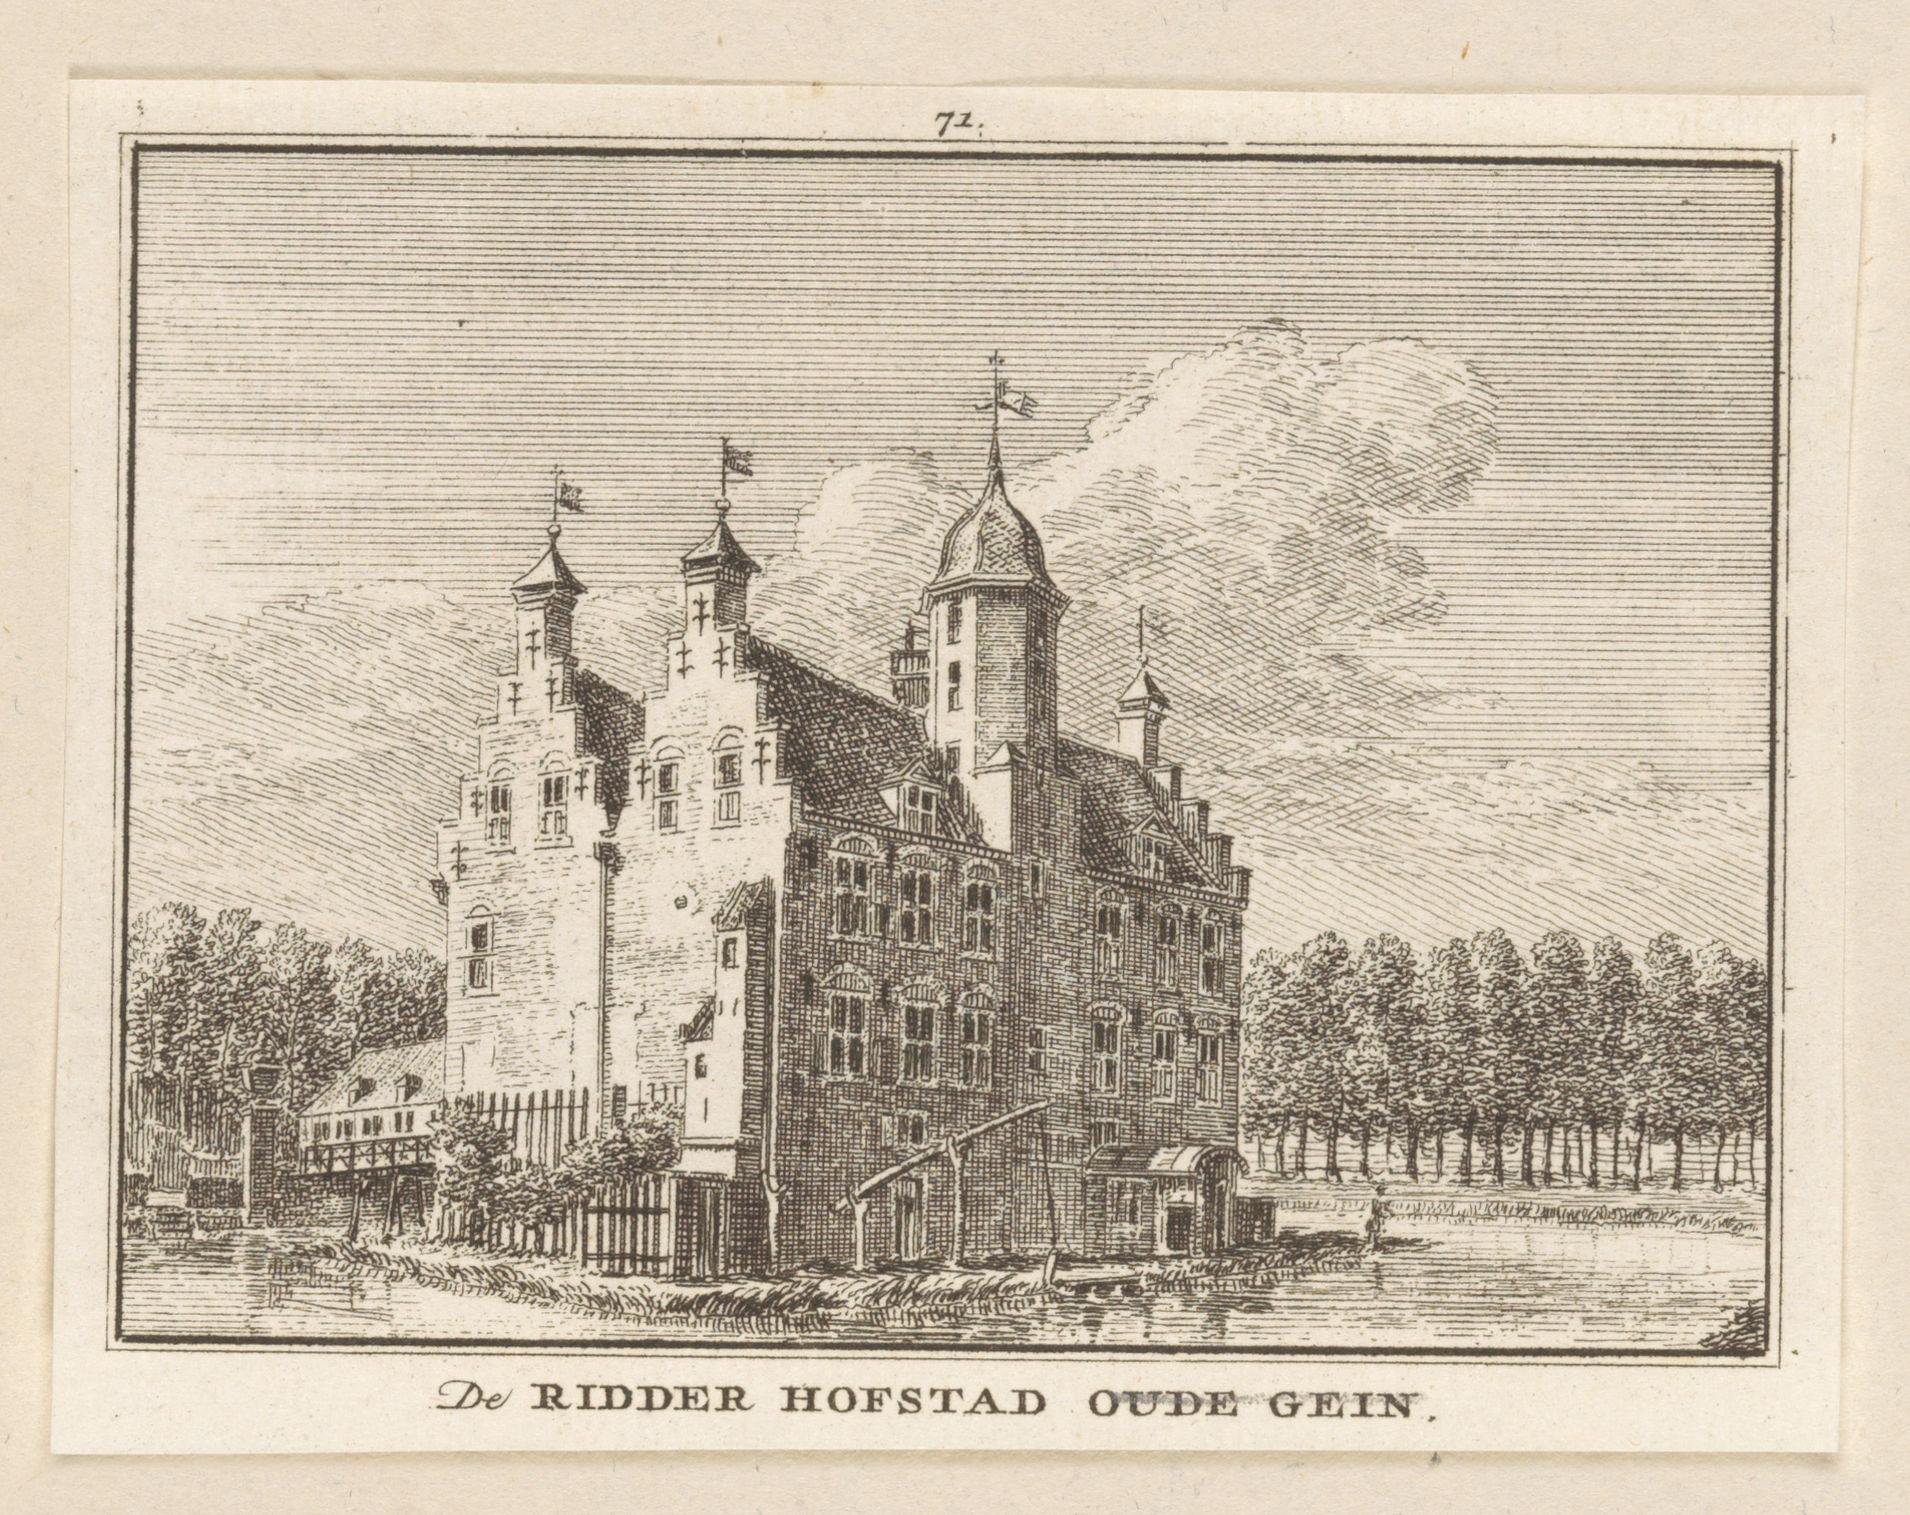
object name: print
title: Gezicht op Kasteel Te Vliet te Lopikerkapel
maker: hendrik spilman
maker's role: draughtsman, painter, print maker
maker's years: 1721-1784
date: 1773-1792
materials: paper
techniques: engraving, etching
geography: haarlem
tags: castle, huis te vliet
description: In tegenstelling tot wat de foutieve titel of het object suggereert gaat het hier niet om kasteel Oudegein te Nieuwegein. Prent ook gebruikt in: Het verheerlykt Nederland of kabinet van hedendaagsche gezigten van steden, dorpen (…). 9 delen. Amsterdam: Isaak Tirion en weduwe Isaak Tirion, 1745-1774, dl. 7, 8 of 9 (weduwe Isaak Tirion, 1773-1774), ill. 71. Of in: Nederlandsche tafereelen; of eene keurige verzameling van negen honderd fraaije gezigten van steden, dorpen, sloten, oudheden (….). 9 delen. Amsterdam: Jan de Groot, 1792, dl. 7, 8 of 9, ill. 71. Uit welke druk het huidige exemplaar precies komt is niet na te gaan.